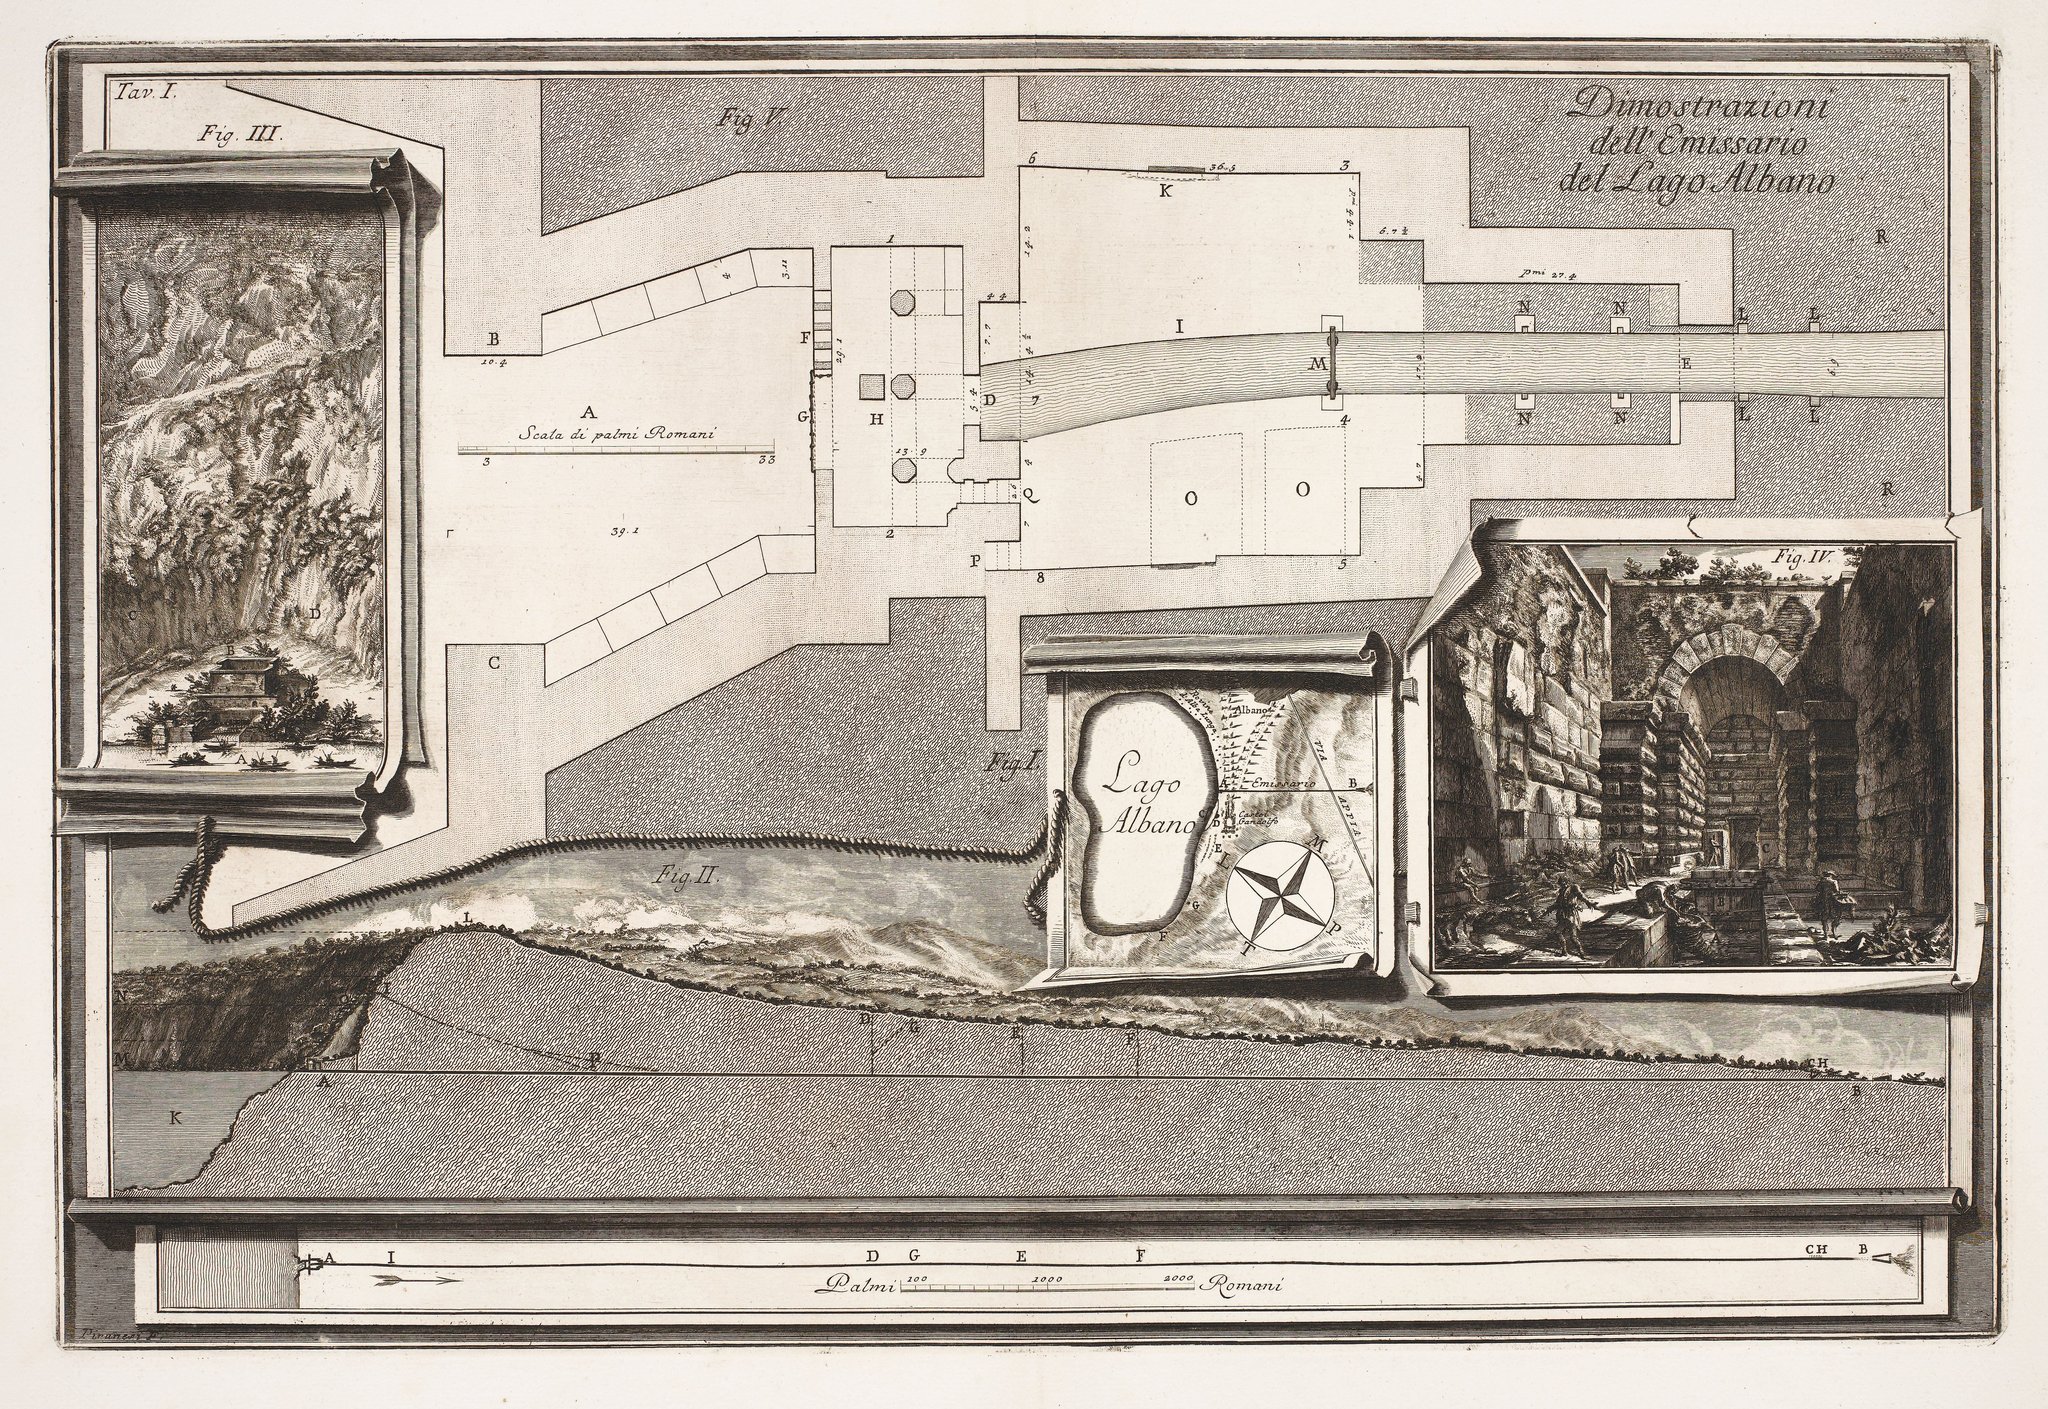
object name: print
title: Beschrijving en ontwerp van het afvoerkanaal van het Meer van Albano door Giovanni Battista Piranesi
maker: giovanni battista piranesi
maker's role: designer, draughtsman, print maker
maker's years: 1720-1778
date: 1762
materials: paper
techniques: etching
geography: rome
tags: sewers, lake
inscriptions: collector's mark: Lugt 2228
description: Deze prent maakt deel uit van de serie 'Descrizione e Disegno dell'Emissario del Lago Albano'. De serie bestaat uit een titelprent, een vignet, een ornamentele letter en negen prenten.